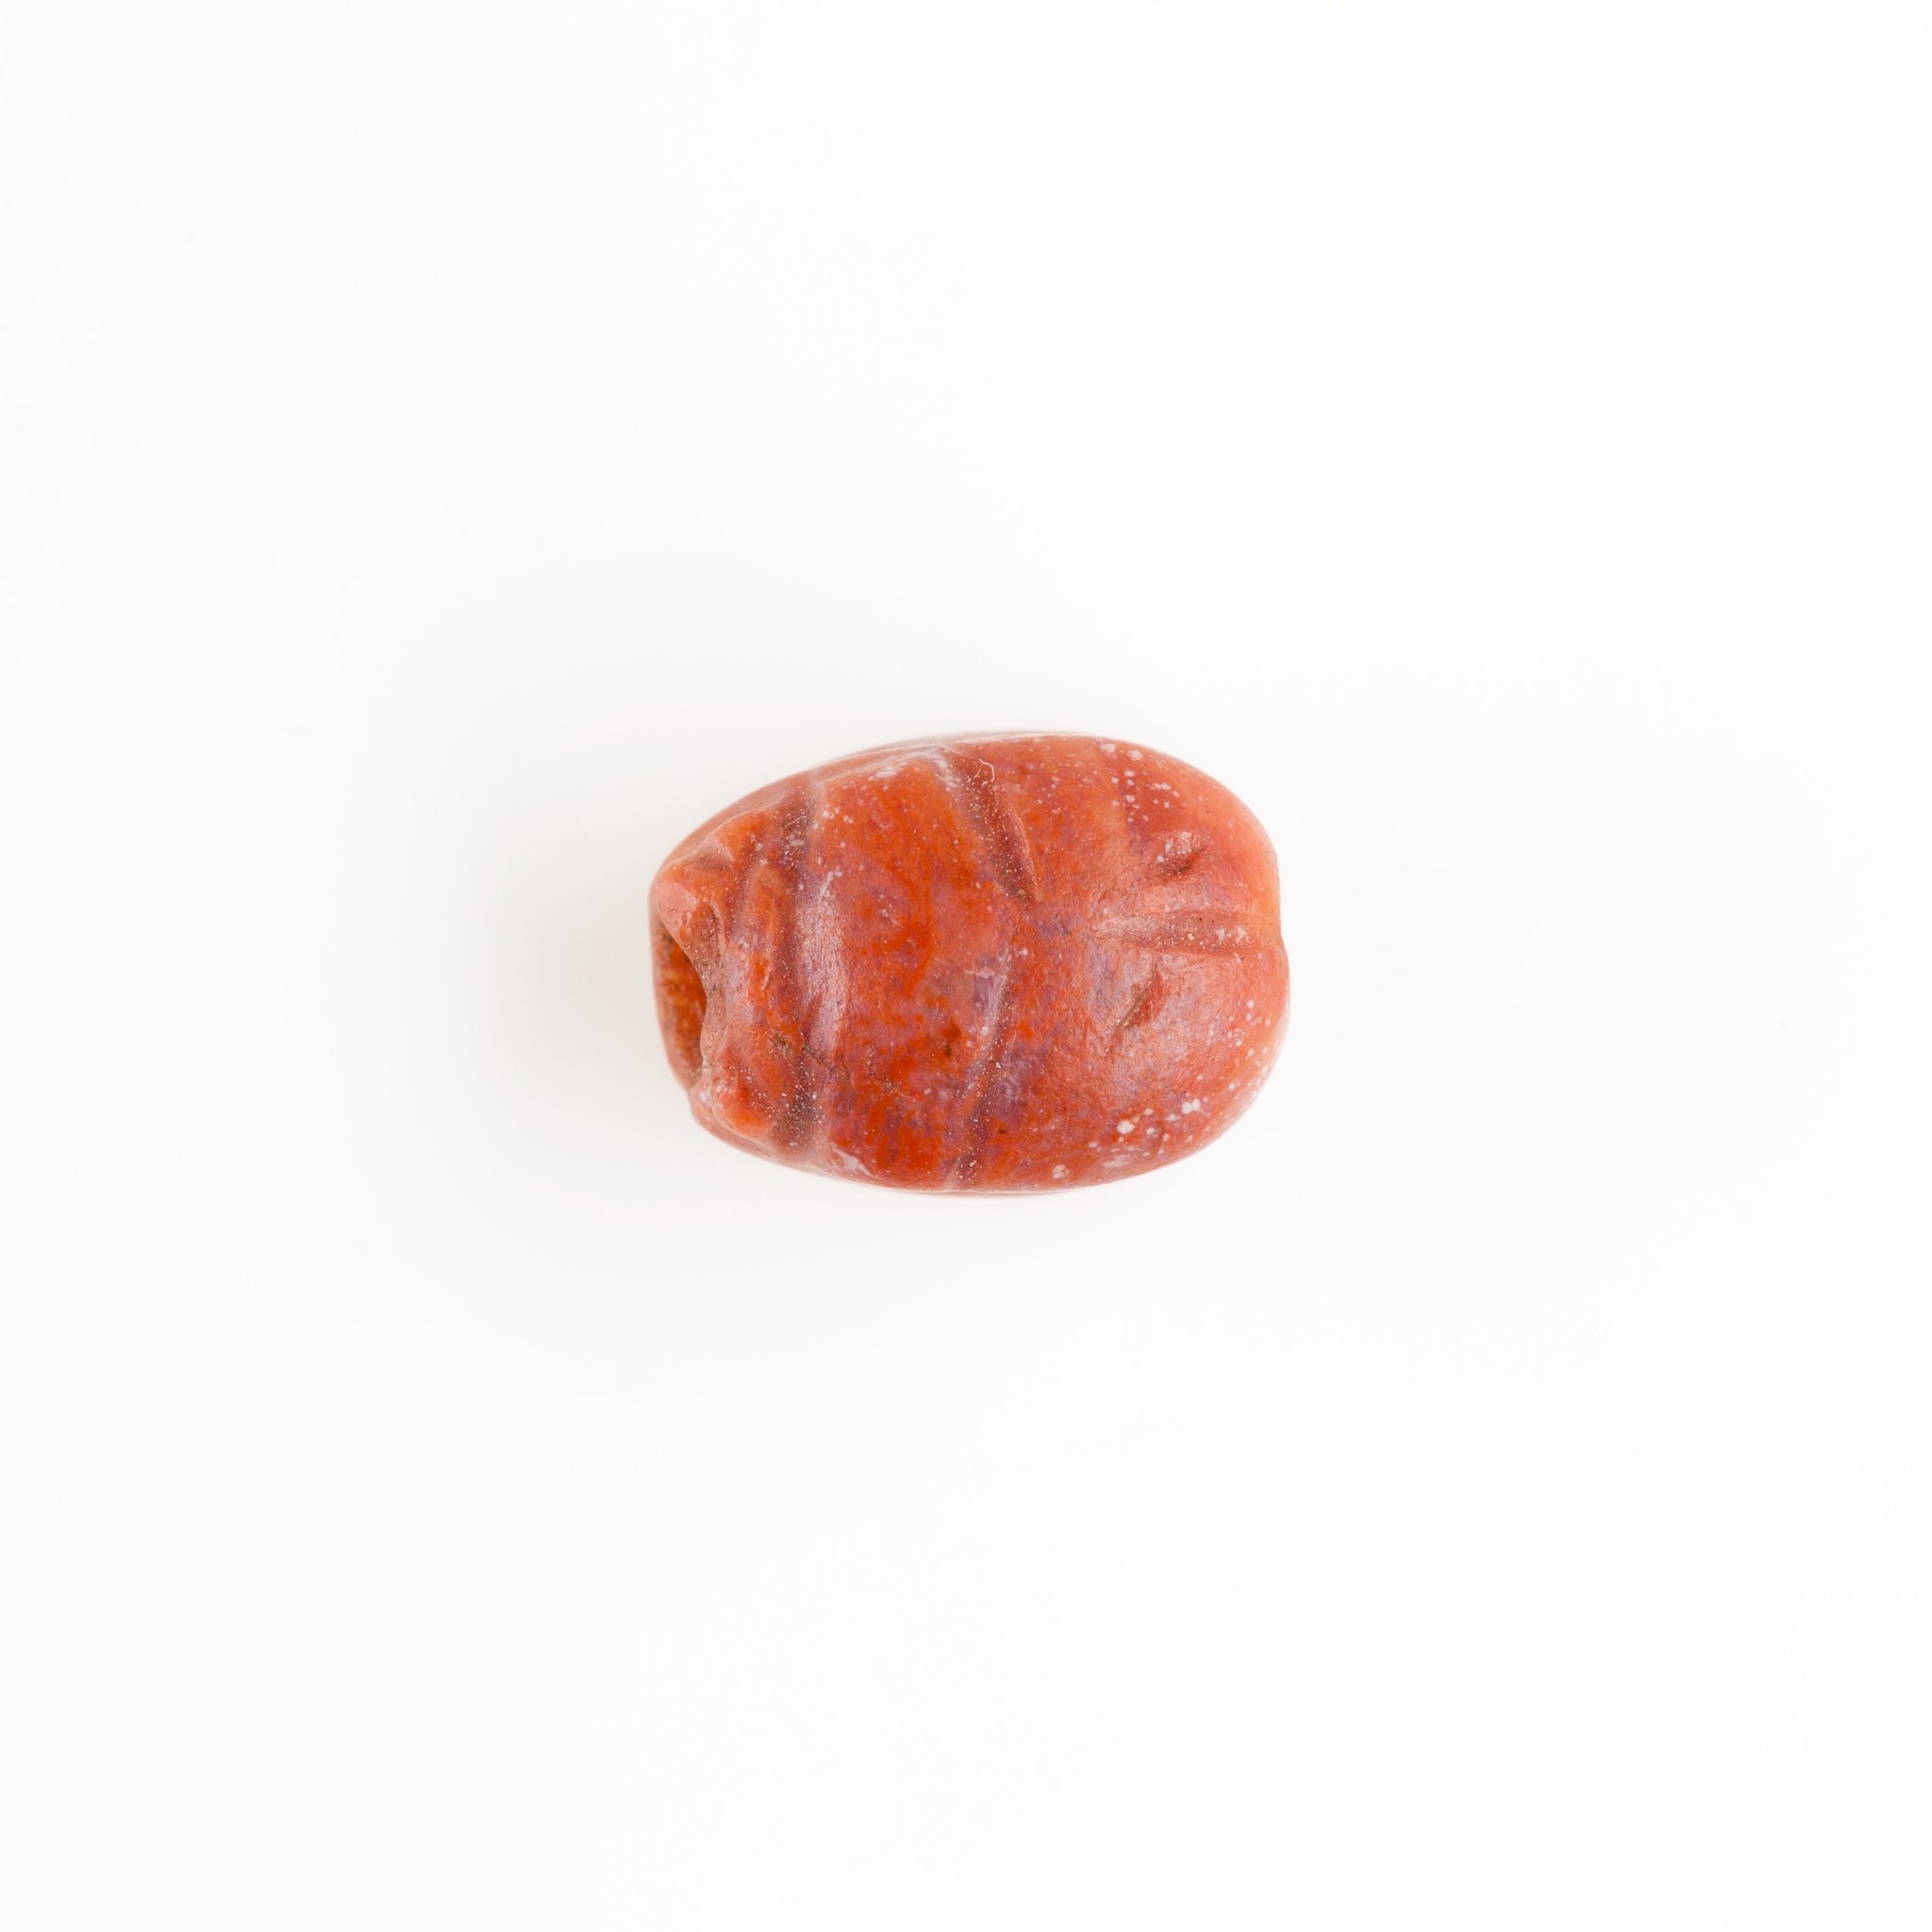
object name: scarab, uninscribed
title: Scarab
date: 1981-1550 BCE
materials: jasper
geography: egypt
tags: scarabs